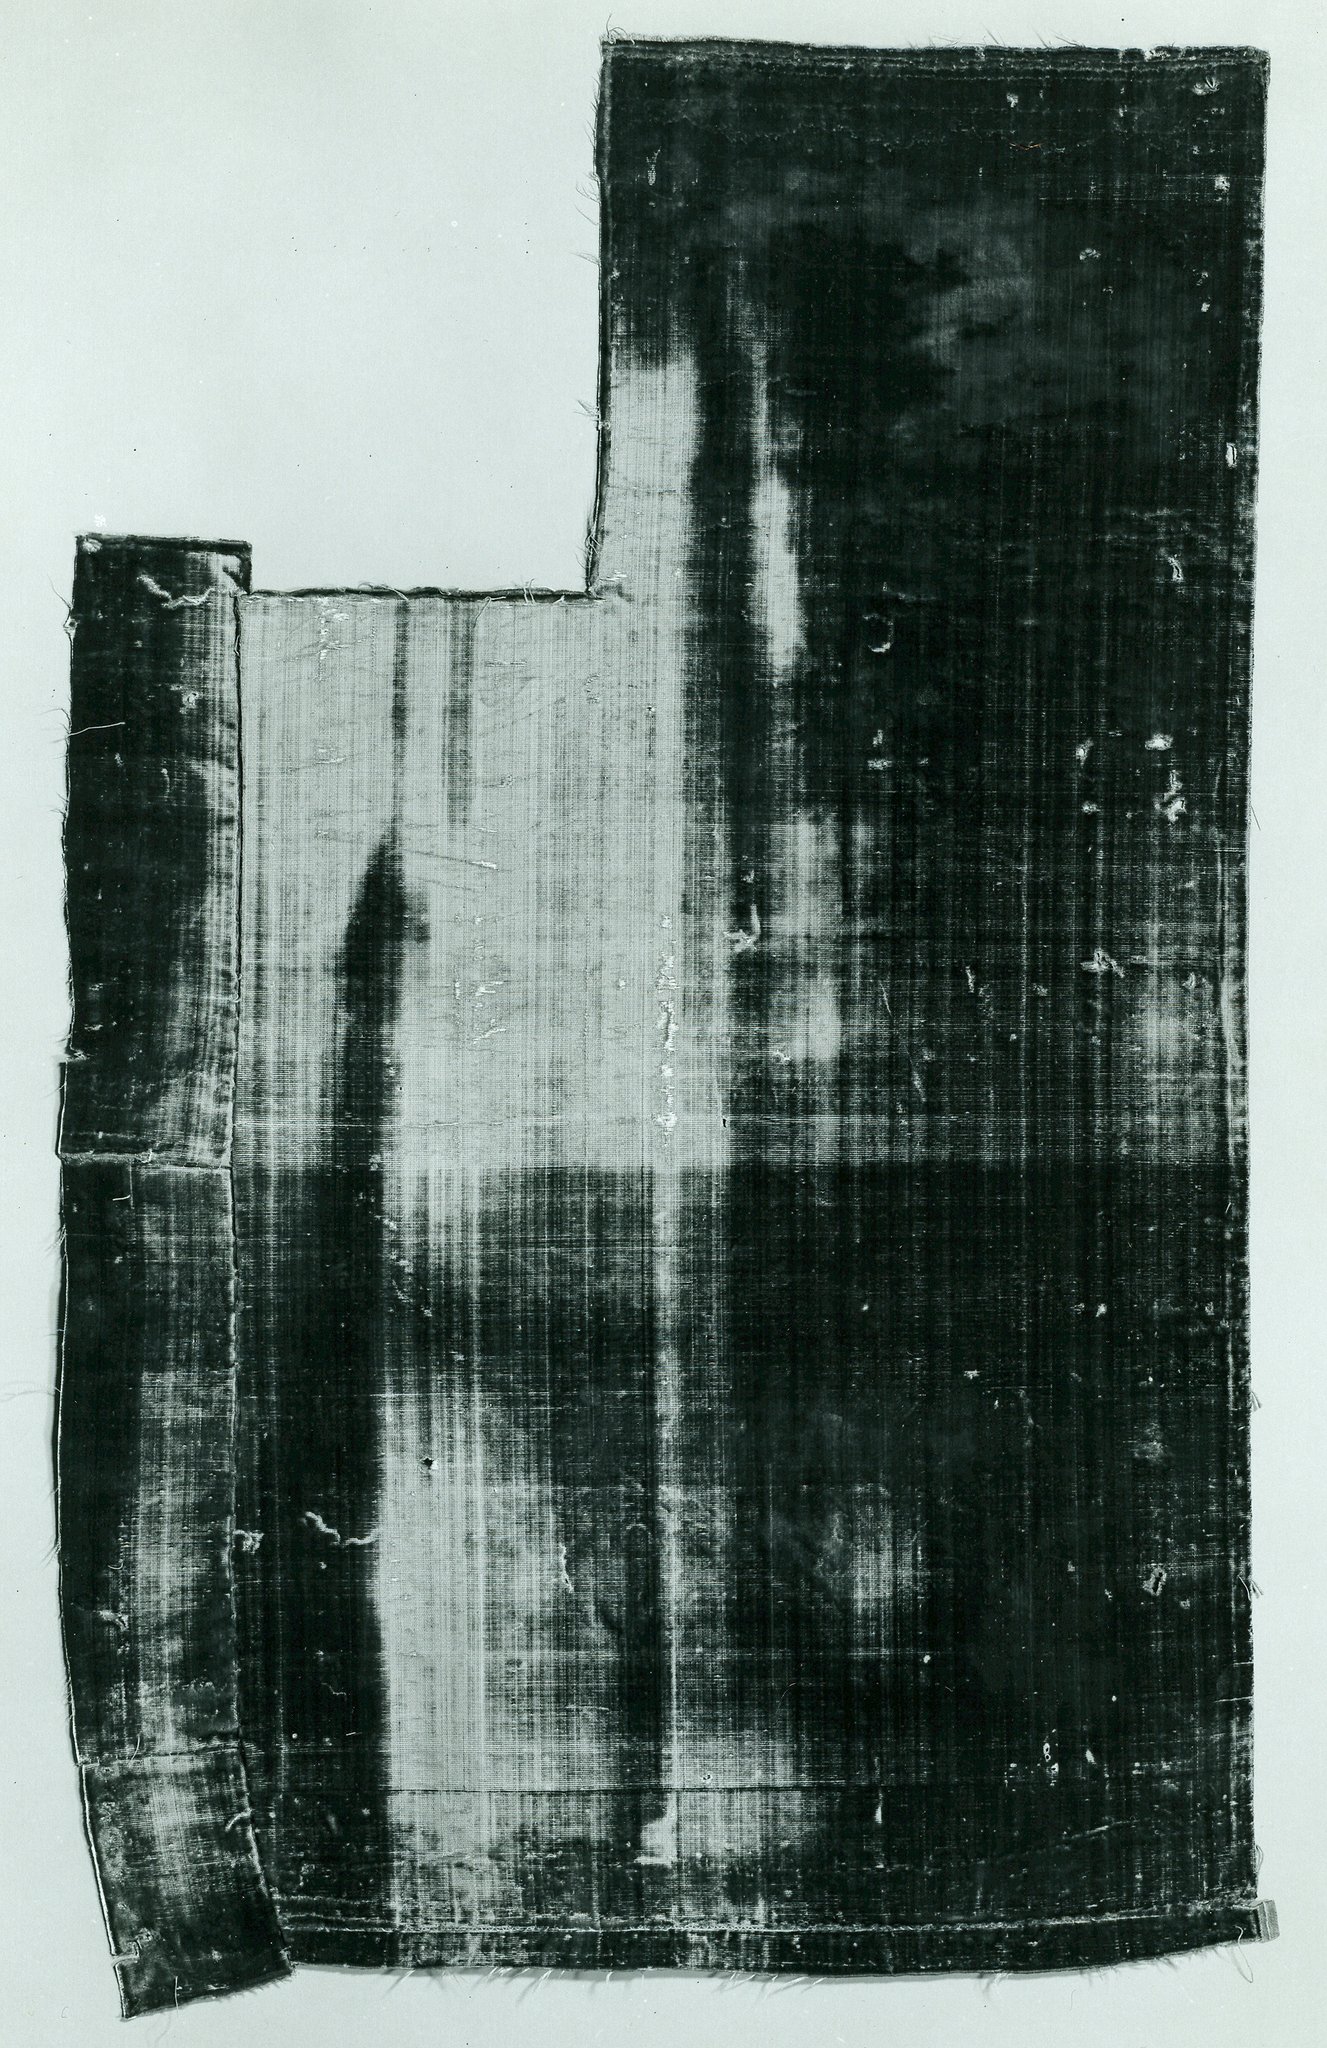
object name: textile fragment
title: Fragment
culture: spanish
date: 1501-1600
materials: silk